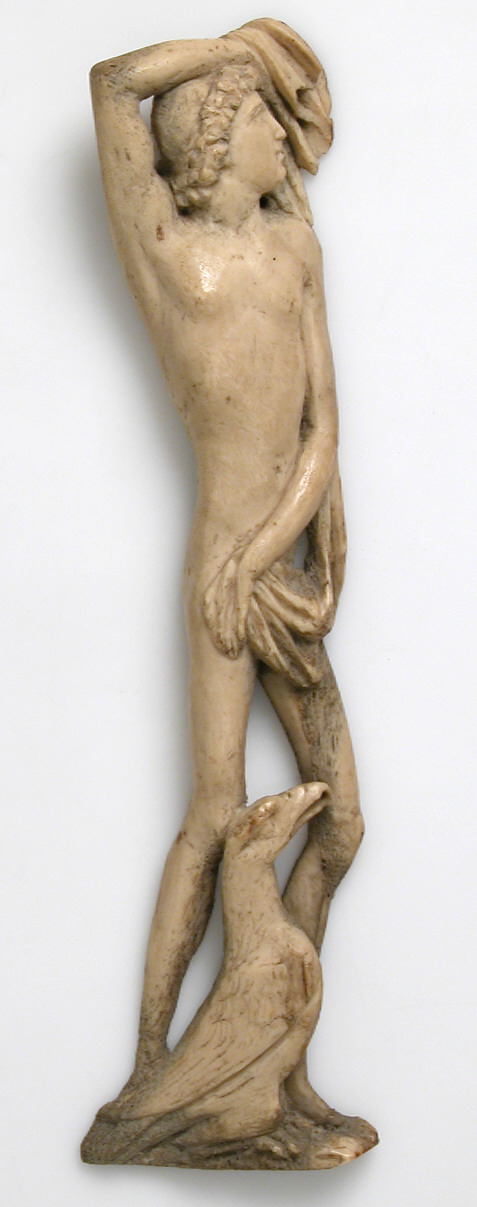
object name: appliqué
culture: byzantine or european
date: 1801-1900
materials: bone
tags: birds